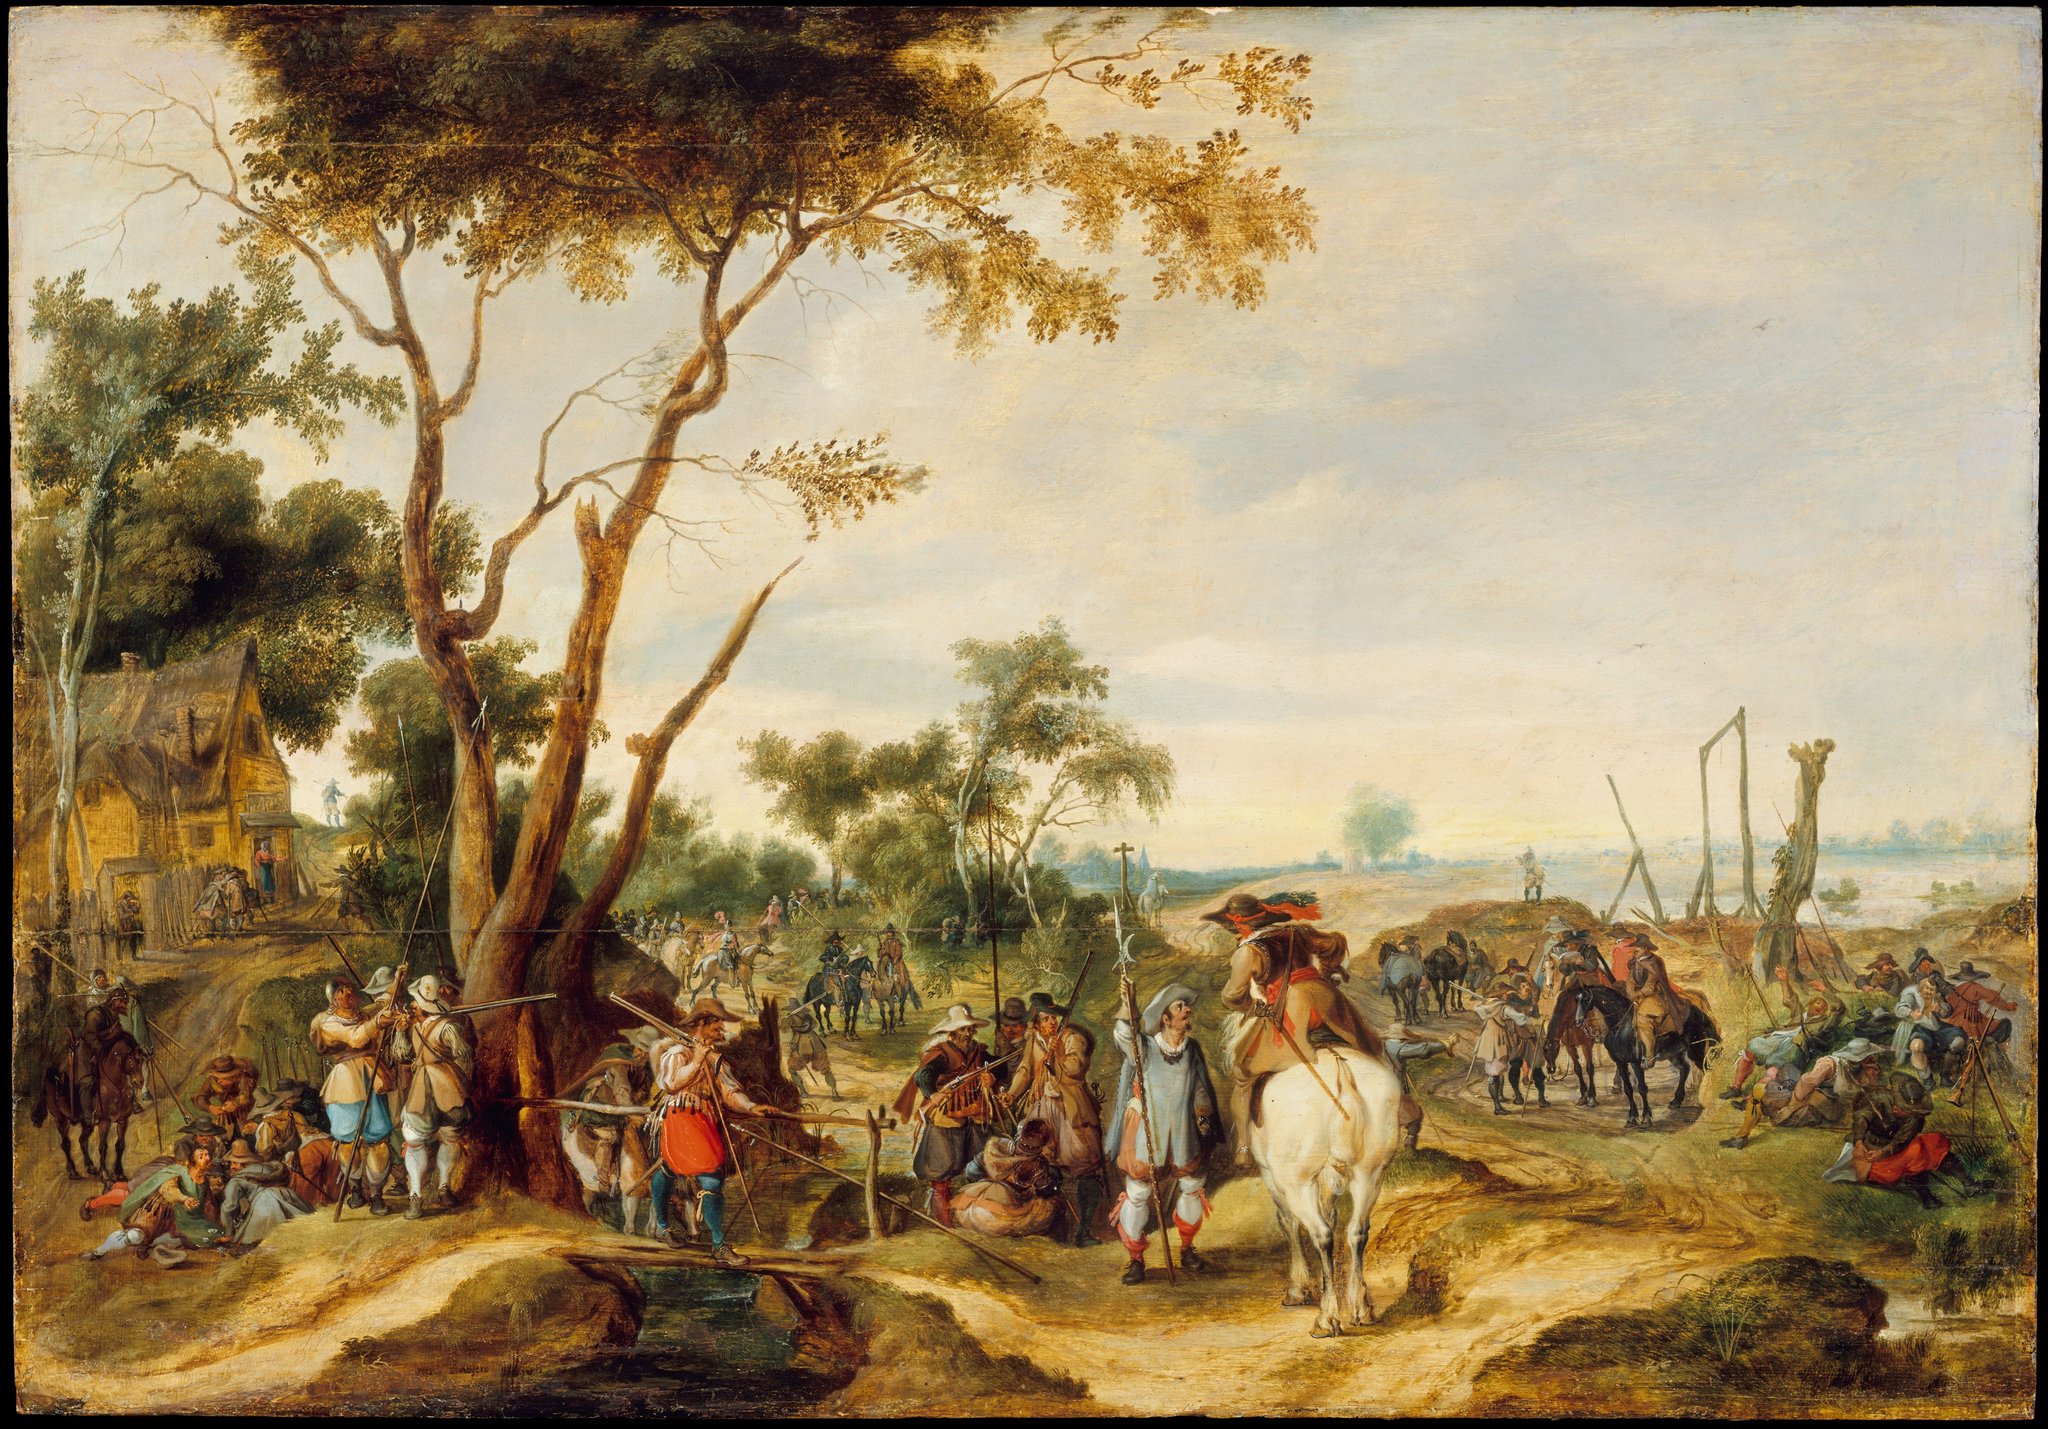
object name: painting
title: Soldiers Bivouacking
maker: pieter snayers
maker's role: artist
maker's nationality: flemish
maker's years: 1592-1667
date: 1612-1667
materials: oil, wood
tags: soldiers,men,horses,landscapes